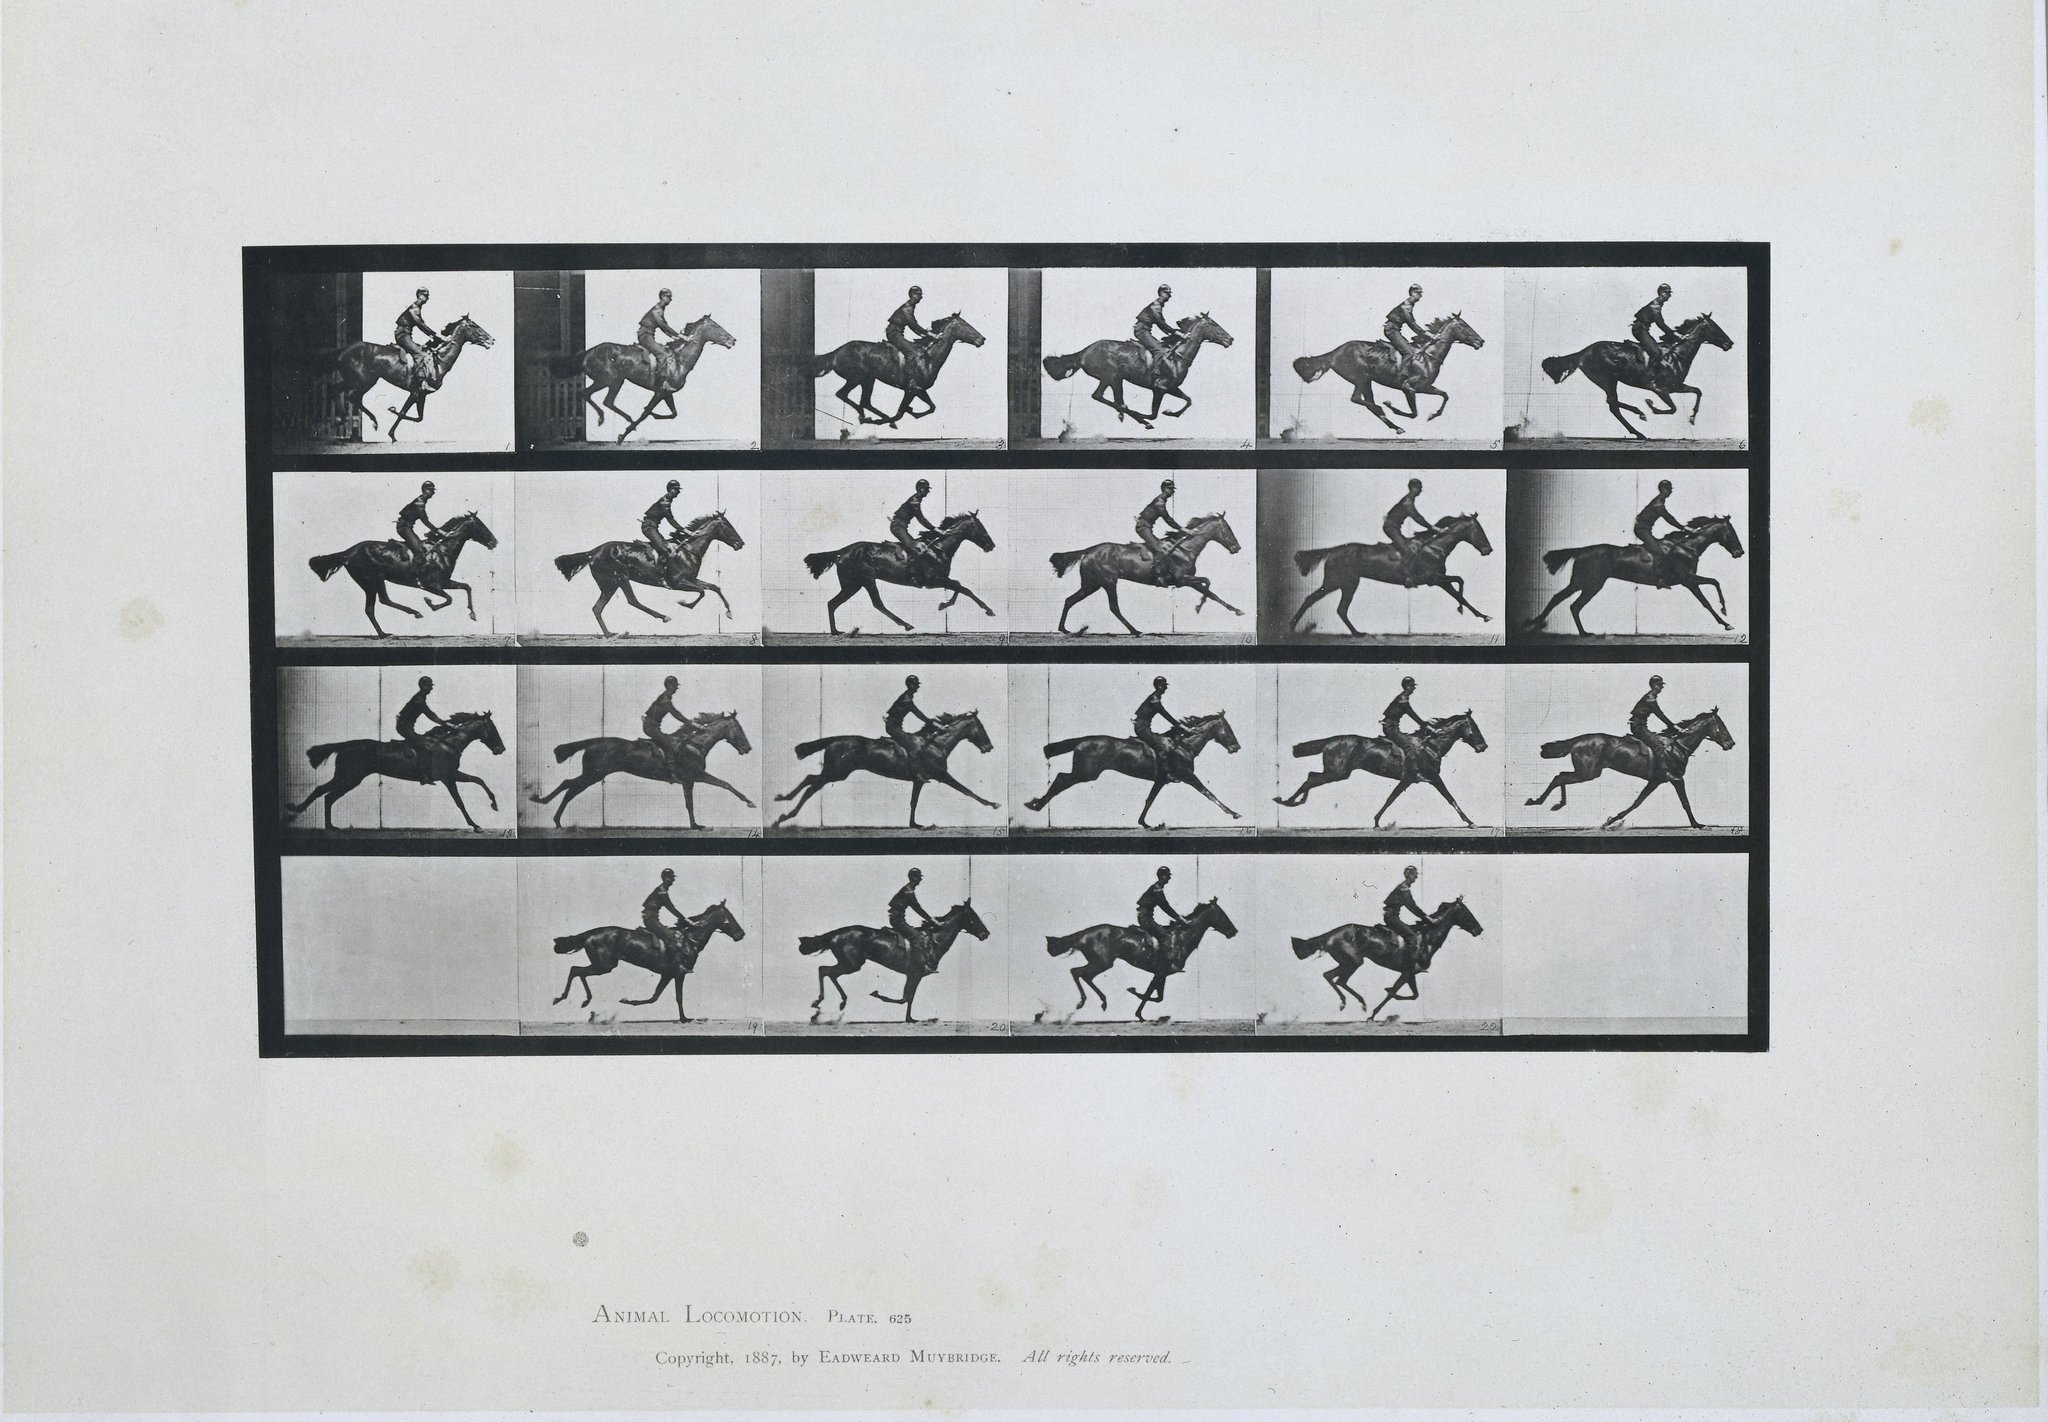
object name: fotosequentie, pocketcinema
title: Gallop; Thoroughbred Bay Horse Bouquet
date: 1887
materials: paper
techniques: photograph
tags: galloping horse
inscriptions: copyright notice: ‘COPYRIGHT, 1887, by EADWEARD MUYBRIDGE. All rights reserved.’, number: ‘PLATE. 625’